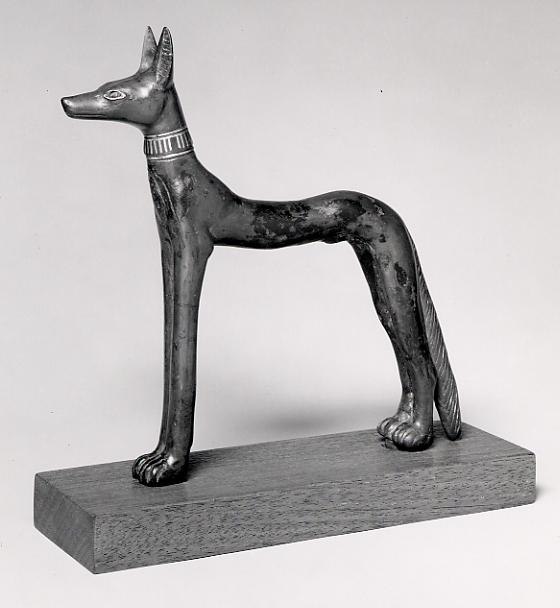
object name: statuette, wepwawet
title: Statuette of Wepwawet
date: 700-332 BCE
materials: bronze, copper alloy, gold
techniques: inlay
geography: egypt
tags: animals